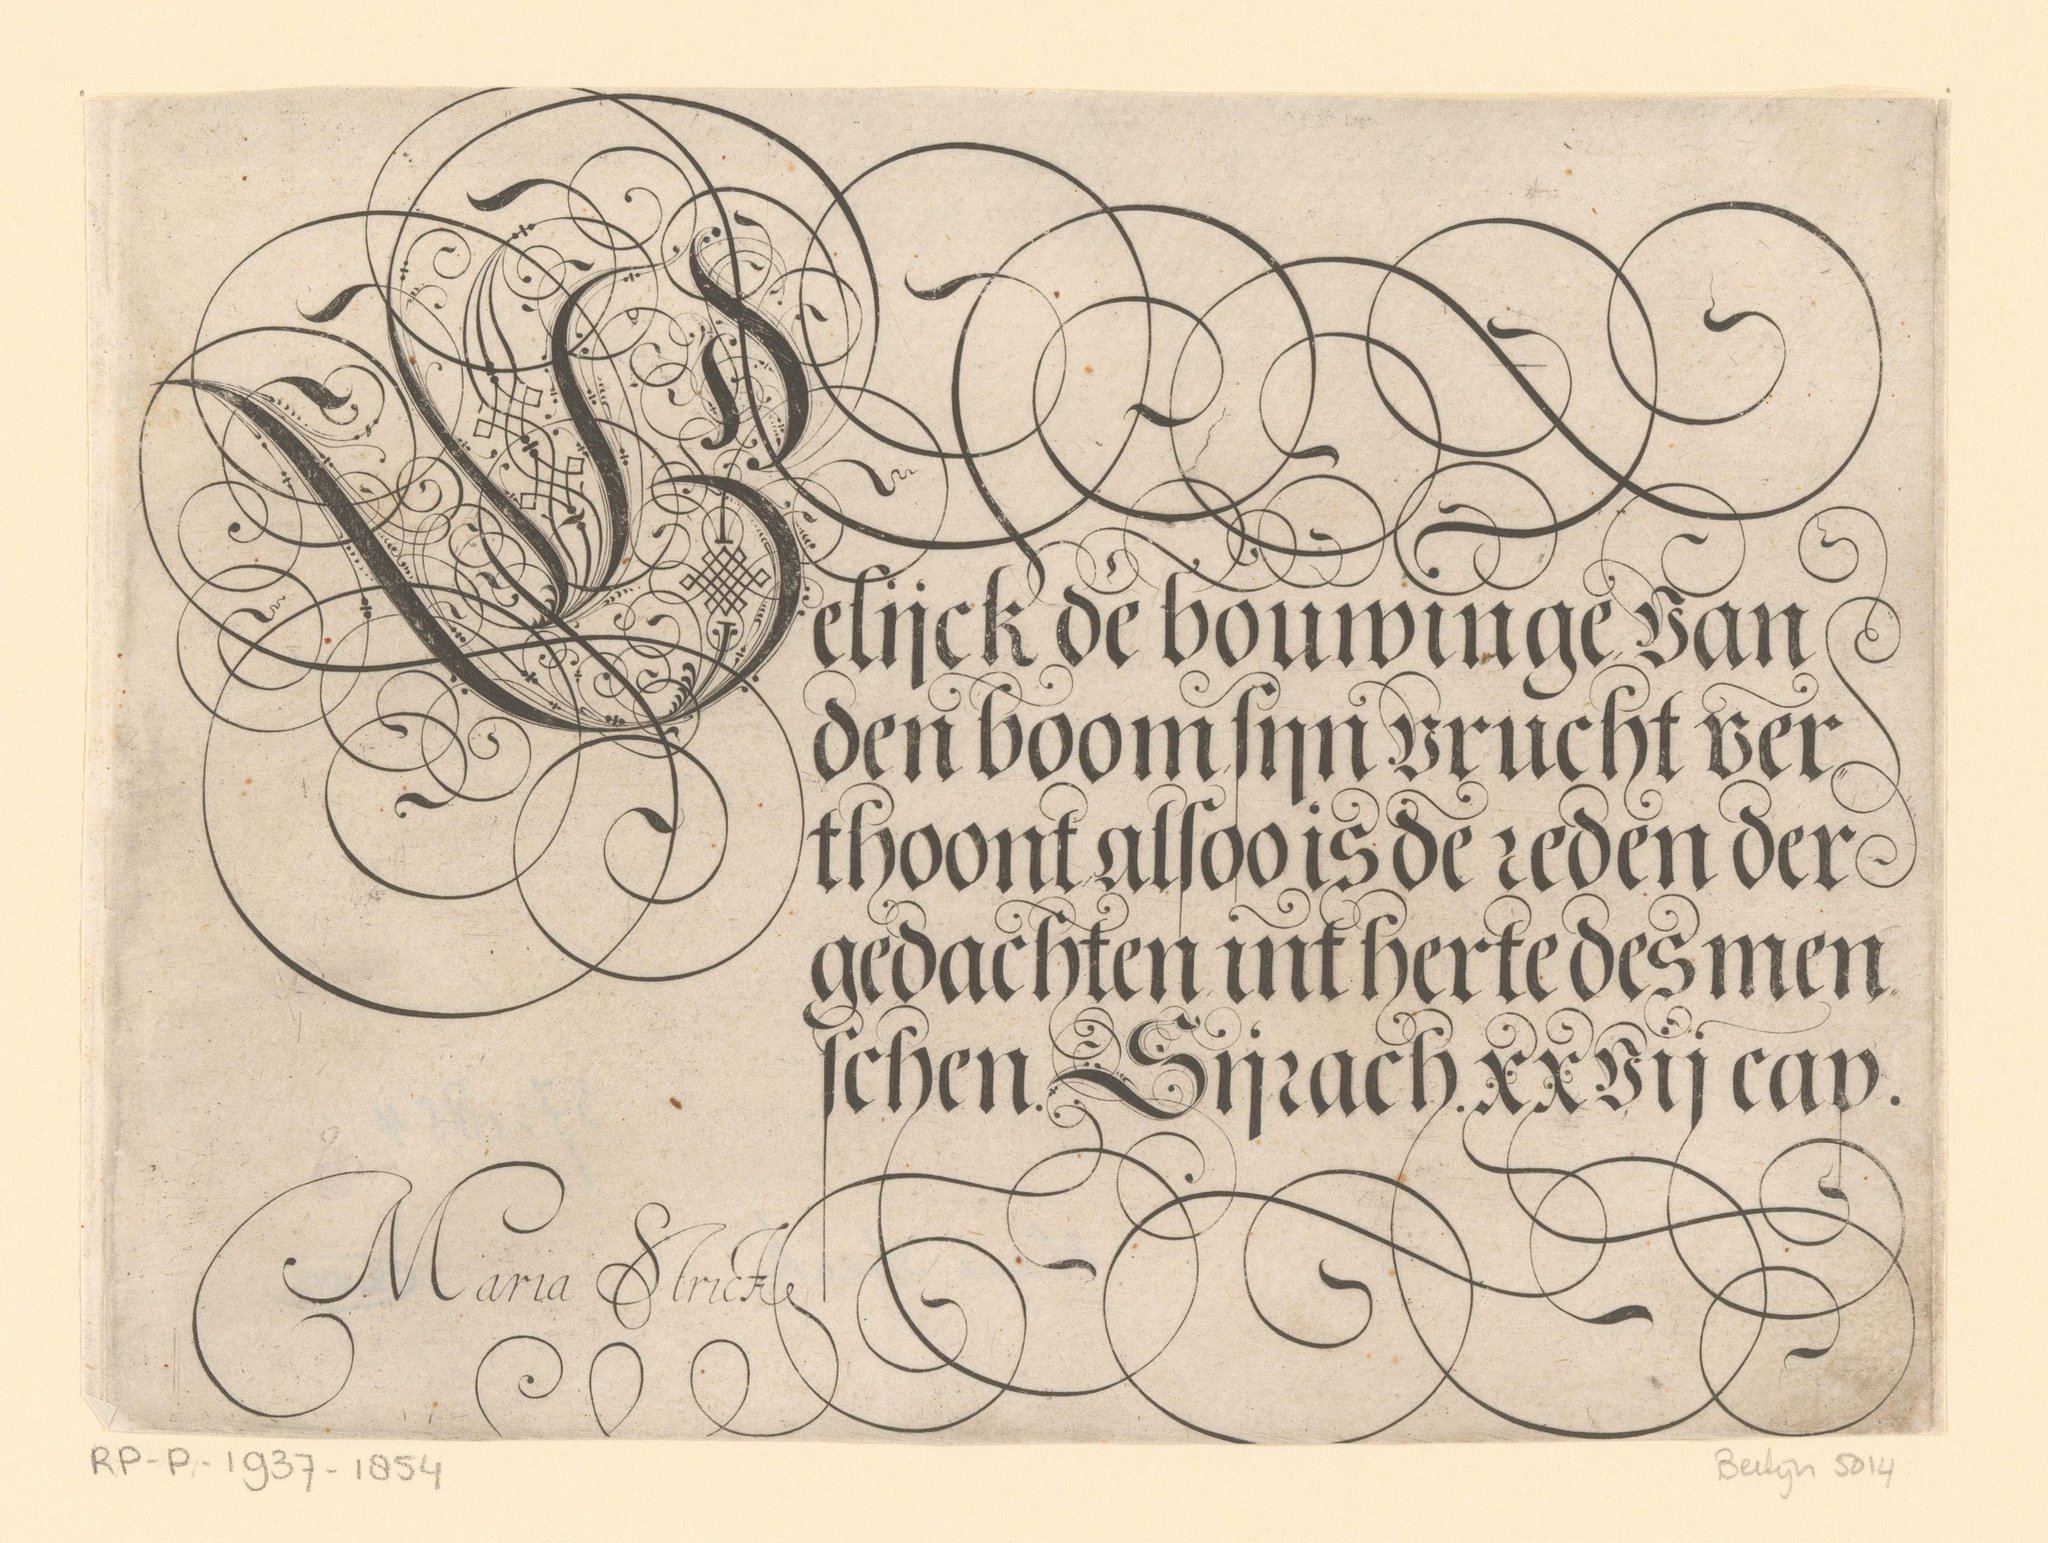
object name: ornament print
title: Schrijfvoorbeeld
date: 1617-1618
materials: paper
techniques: engraving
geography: delft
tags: calligraphy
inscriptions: collector's mark: Lugt 2228, collector's mark: Lugt 2760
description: Gekalligrafeerde tekst: Gelijk de bouwinge van den boom (...)